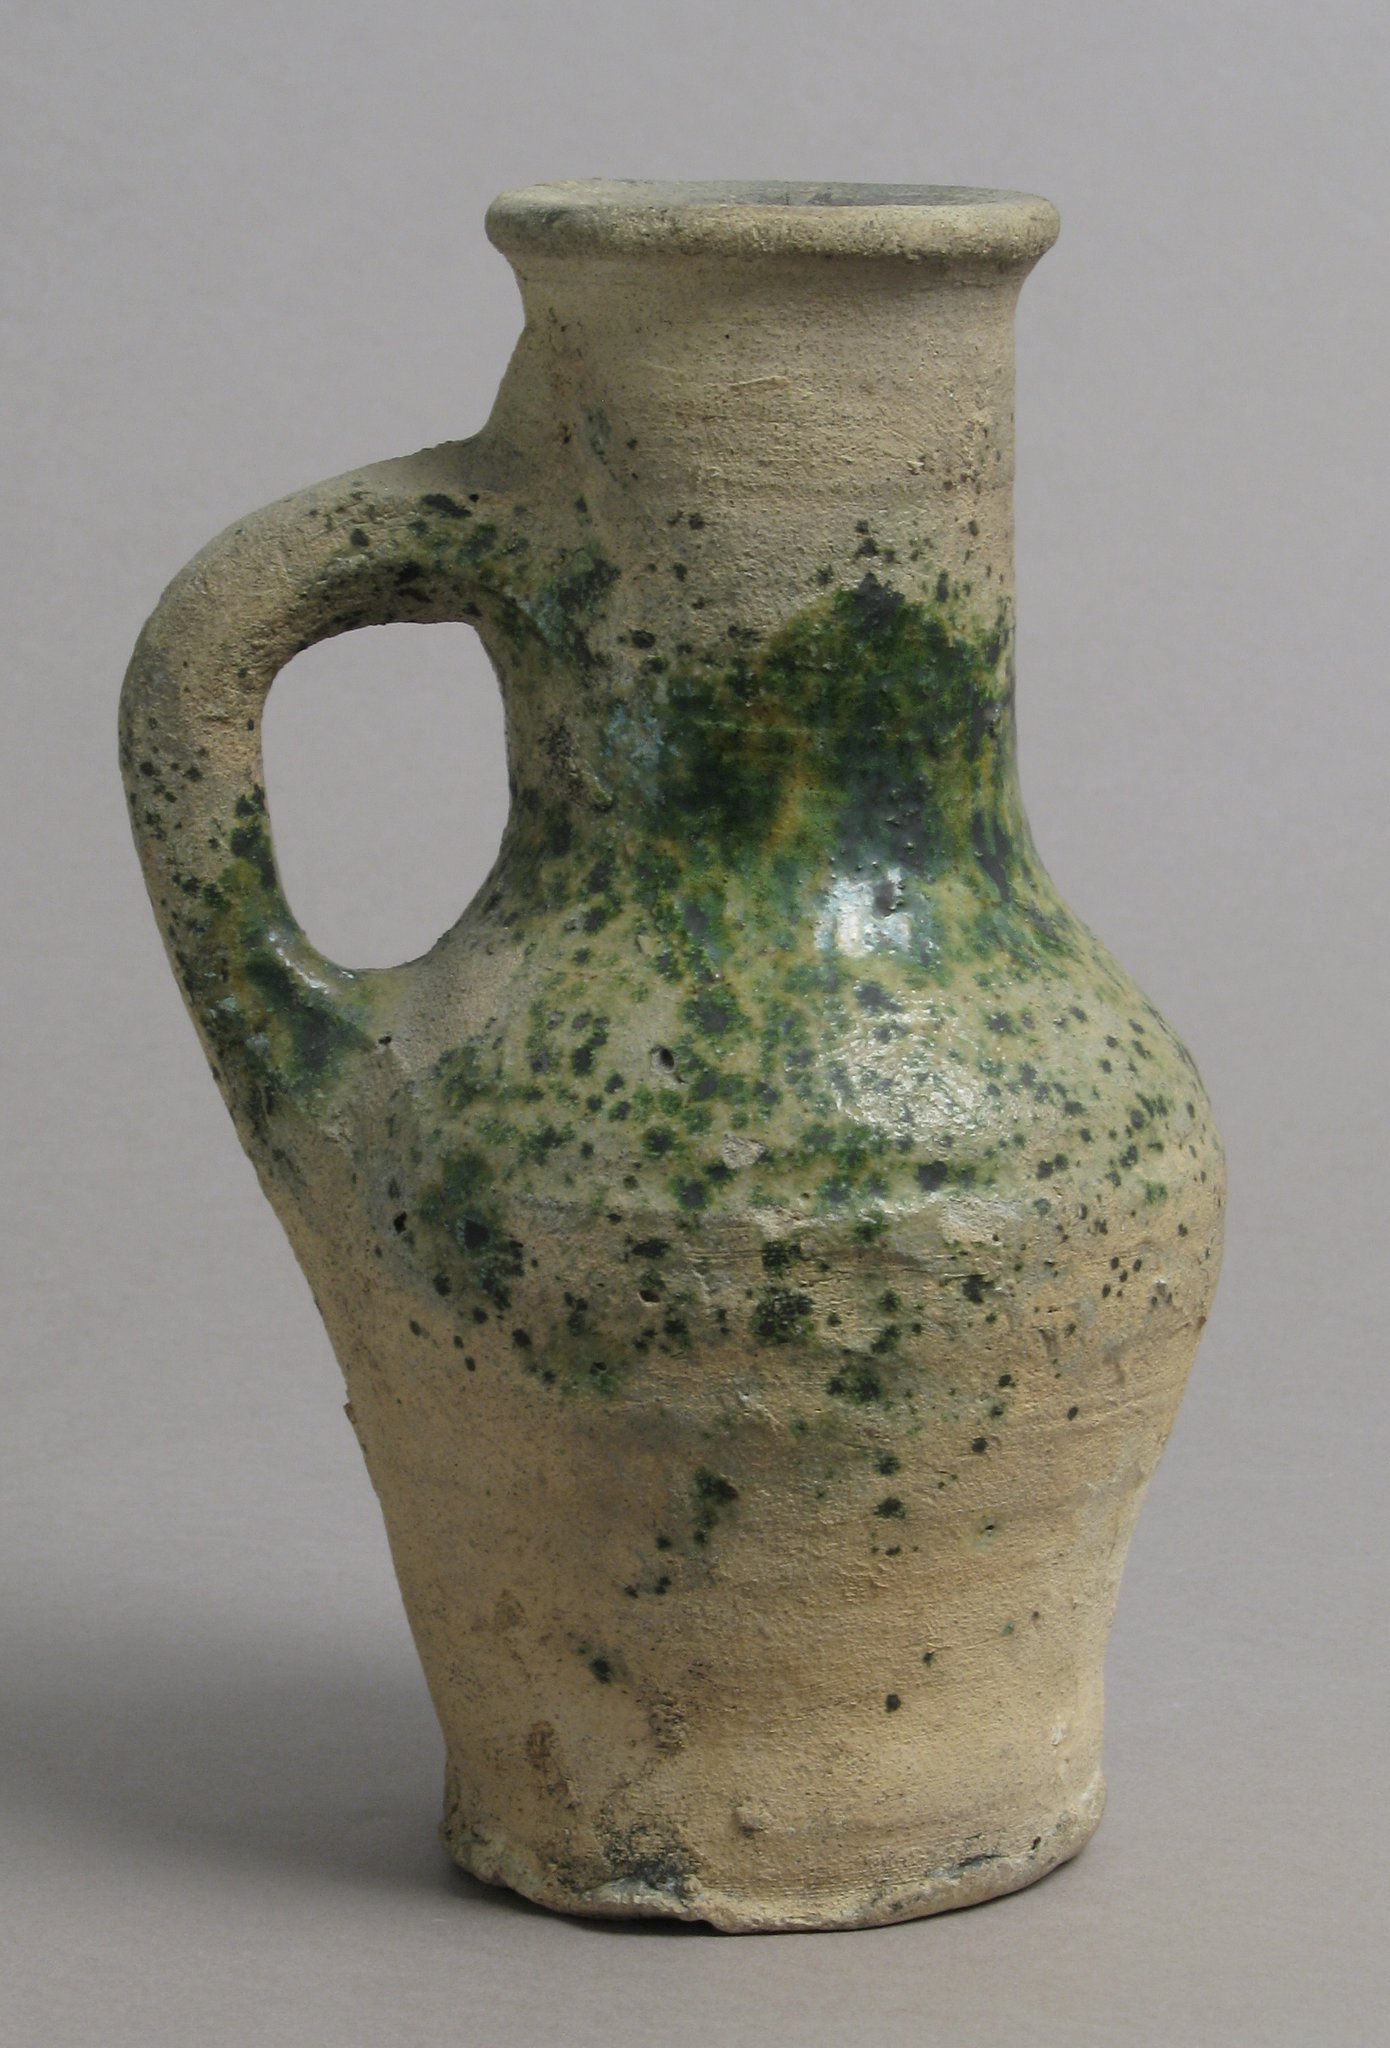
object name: jug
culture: british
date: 1201-1500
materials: earthenware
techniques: glazing